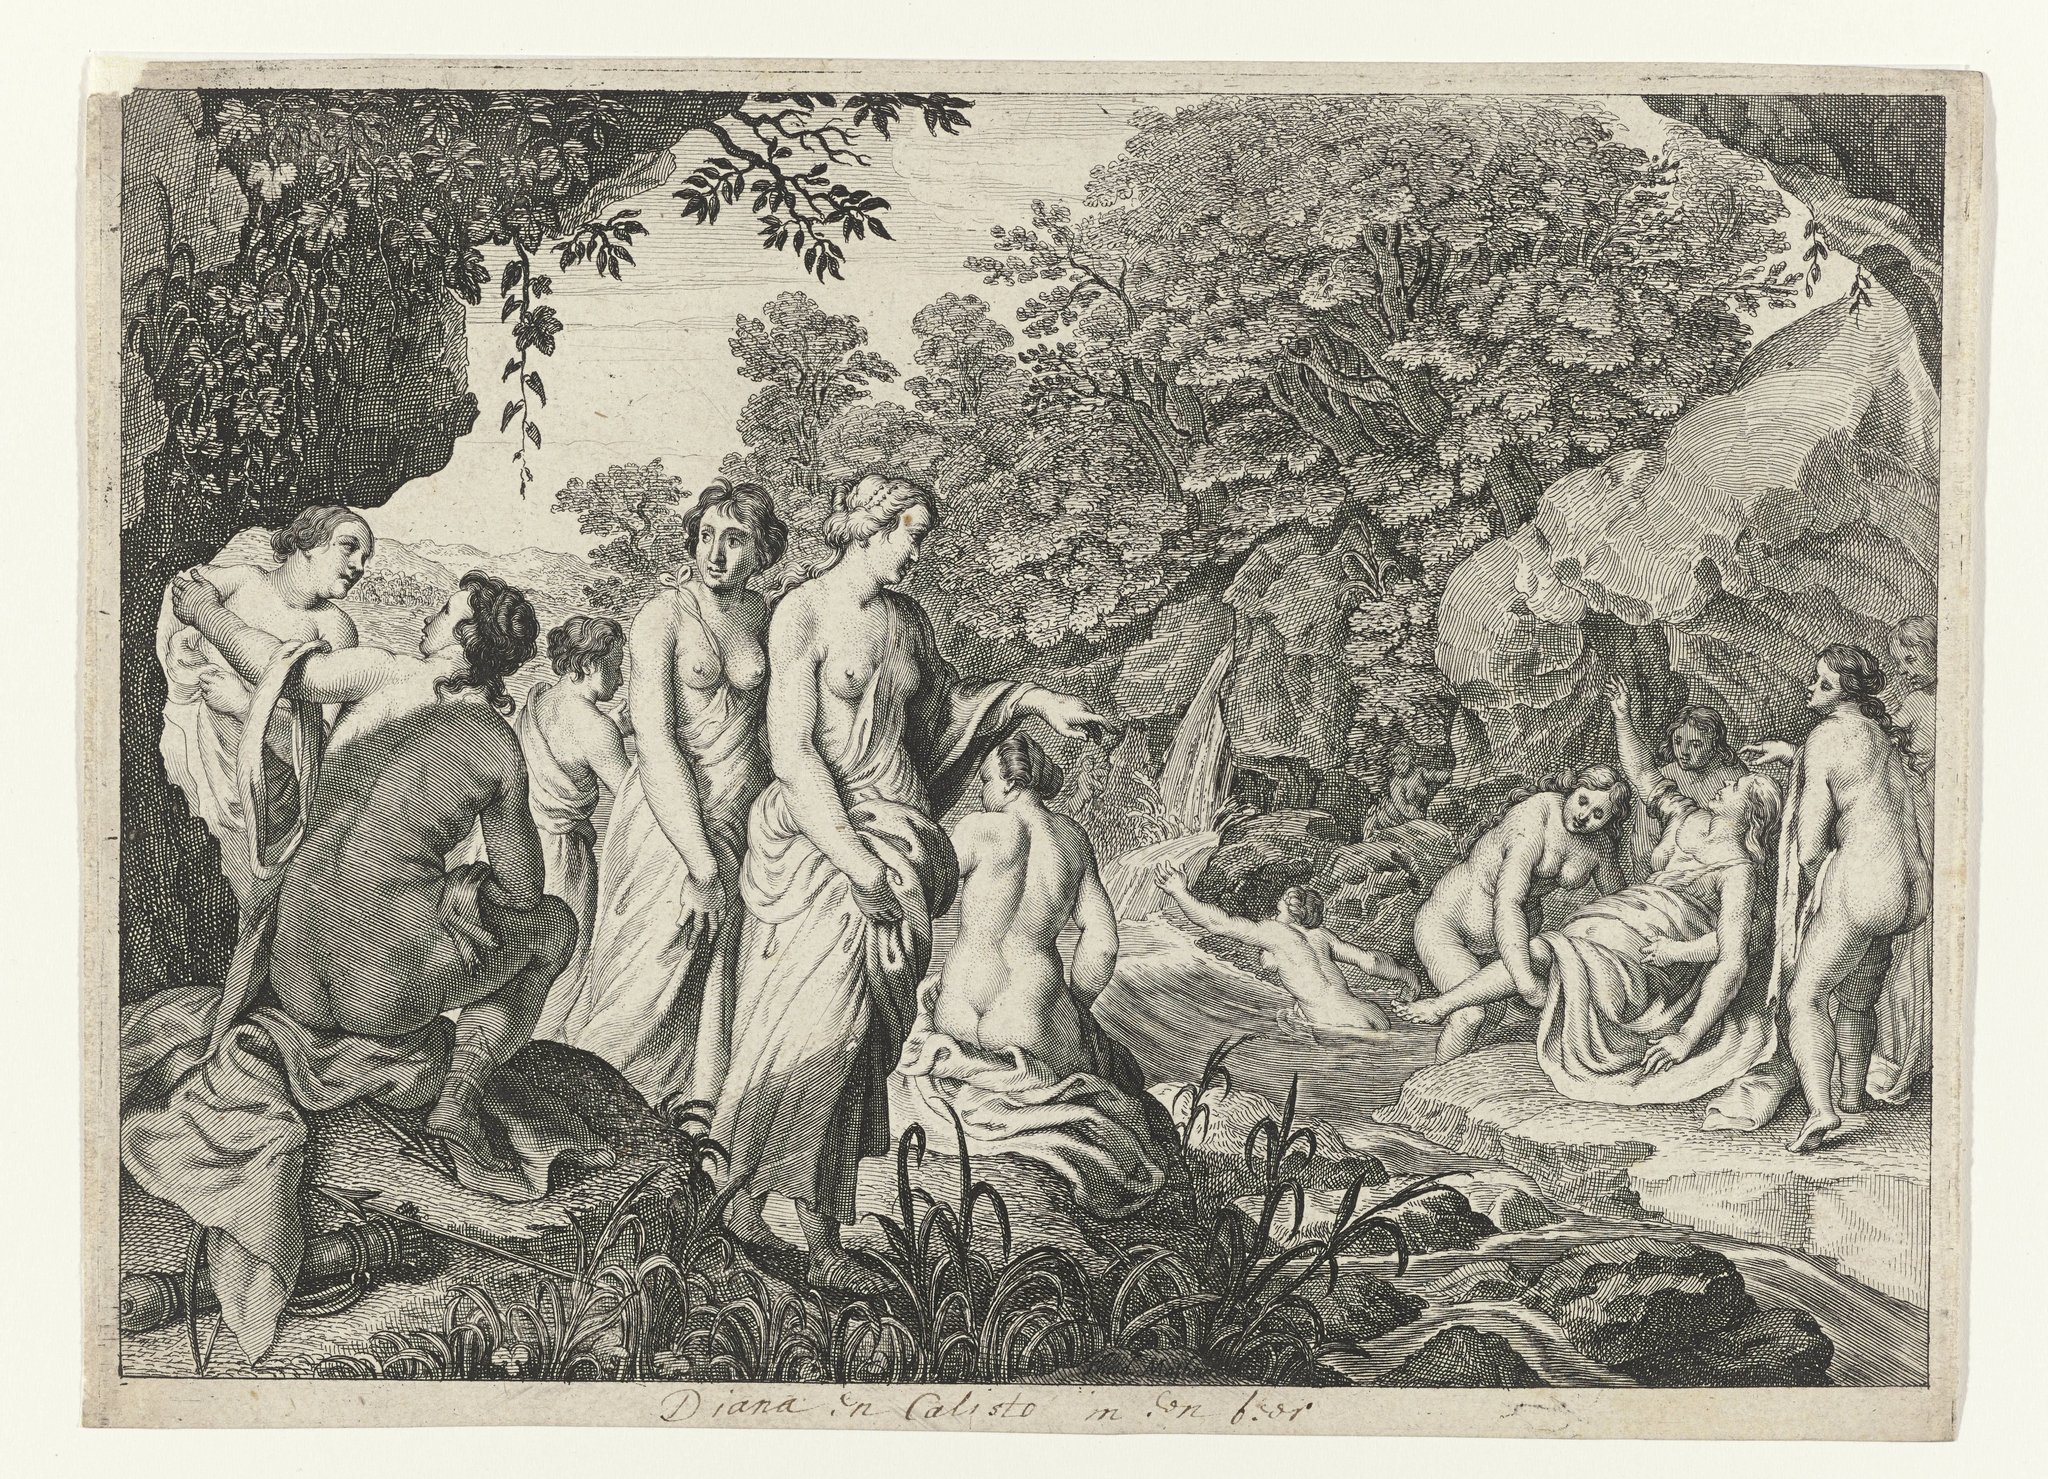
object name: print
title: Metamorfosen van Ovidius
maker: theodor matham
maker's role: draughtsman, print maker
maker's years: 1605-1676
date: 1636-1670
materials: paper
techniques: engraving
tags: diana with her nymphs discovers the pregnancy of callisto, pregnancy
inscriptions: number: ‘18’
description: De ambitieuze reeks naar ontwerpen van ondermeer Jacob Pynas, Roeland Savery, Pieter Clouwet, Rubens en Rembrandt is nooit voltooid door de De Passes. De reeks werd uiteindelijk in 1677 in boekvorm uitgegeven in Brussel door Piere Du Rayer en Francois Foppes. Als losse prenten is de reeks alleen bekend uit een groep prenten afkomstig uit de collectie Hinloopen (1619-1708) die zich in het Rijksprentenkabinet bevindt. Deze groep is uitgebreid beschreven door Jan van der Waals in zijn Hinloopen-catalogus (zie: ''Een onbekende editie van een serie Ovidius-illustraties'' in De prentschat van Michiel Hinloopen, 1988, p. 79-102.). De ontdekking van een tweede groep afdrukken van de reeks, afkomstig uit de werkplaats van Crispijn de Passe de Jonge, biedt een belangrijke aanvulling op de Hinloopen-groep. Sommige afdrukken tonen de prenten in onvoltooide staat en zijn voorzien van verbeteringen en toevoegingen in pen en penseel. Bovendien zijn alle prenten voorzien van 17de-eeuwse opschriften die het in een aantal gevallen mogelijk maakt de ontwerpers van de voorstellingen nader te identificeren. Op grond van de aangetroffen watermerken kunnen de afdrukken worden gedateerd omstreeks 1652-1653.